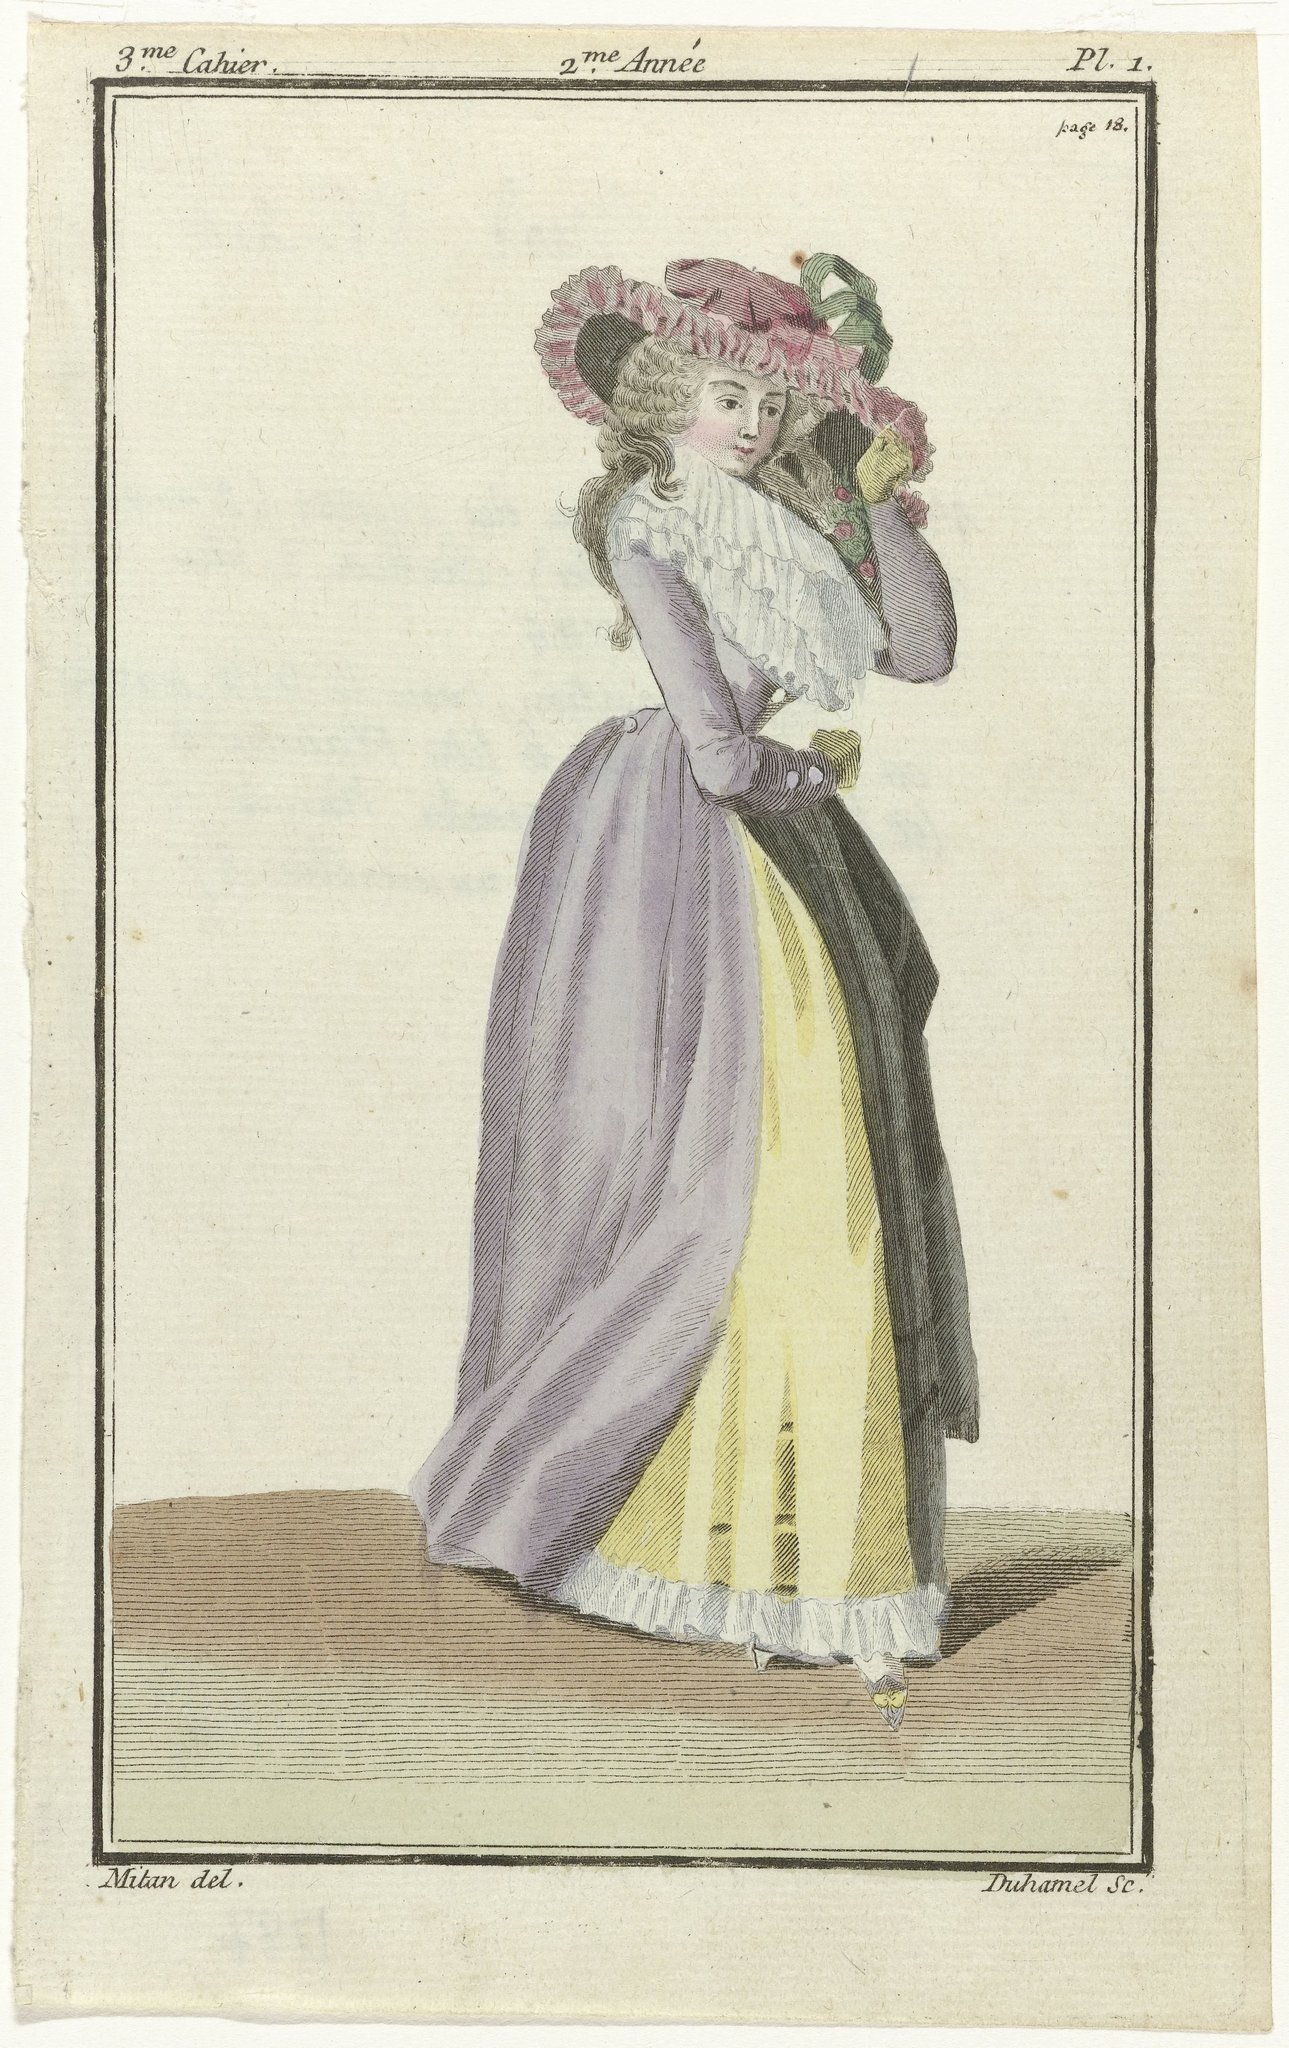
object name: fashion print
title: Magasin des Modes Nouvelles Françaises et Anglaises, 10 décembre 1786, 2e Année, 3e cahier, Pl. 1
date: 1786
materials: paper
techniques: engraving, hand coloring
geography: paris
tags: dress, gown: redingote (+ women's clothes), head-gear (+ women's clothes), fashion plates, shoes, sandals (+ women's clothes), skirt (+ women's clothes), gloves, mittens, etc. (+ women's clothes), piece of clothing covering the breast or décolleté (fichu) (+ women's clothes)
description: Jonge Engelse vrouw in een redingote van paars satijn op een vest en rok van geel satijn. De prent maakt deel uit van het 3e Cahier uit de serie Magasin des Modes Nouvelles Françaises et Anglaises. De serie bestaat uit 172 modeprenten, uitgegeven door Buisson, Parijs, 20 november 1786 - 21 décembre 1789.